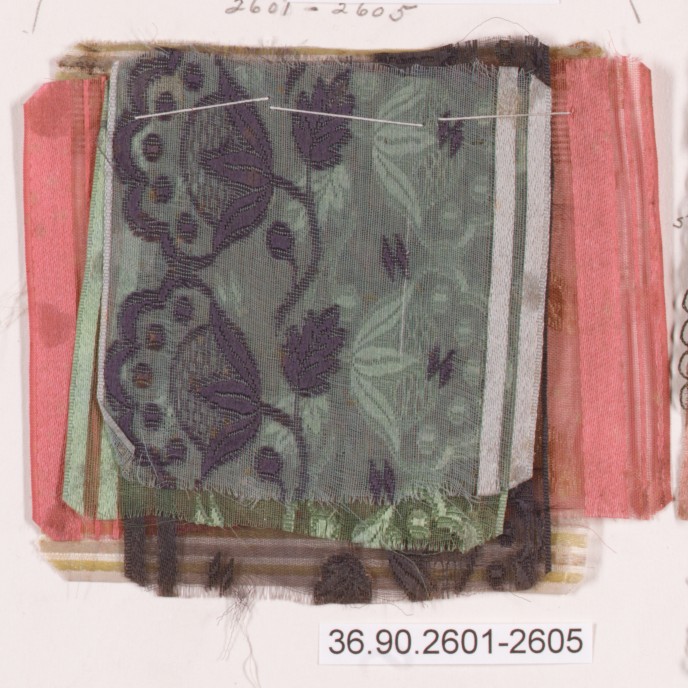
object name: ribbon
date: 1801-1900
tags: flowers